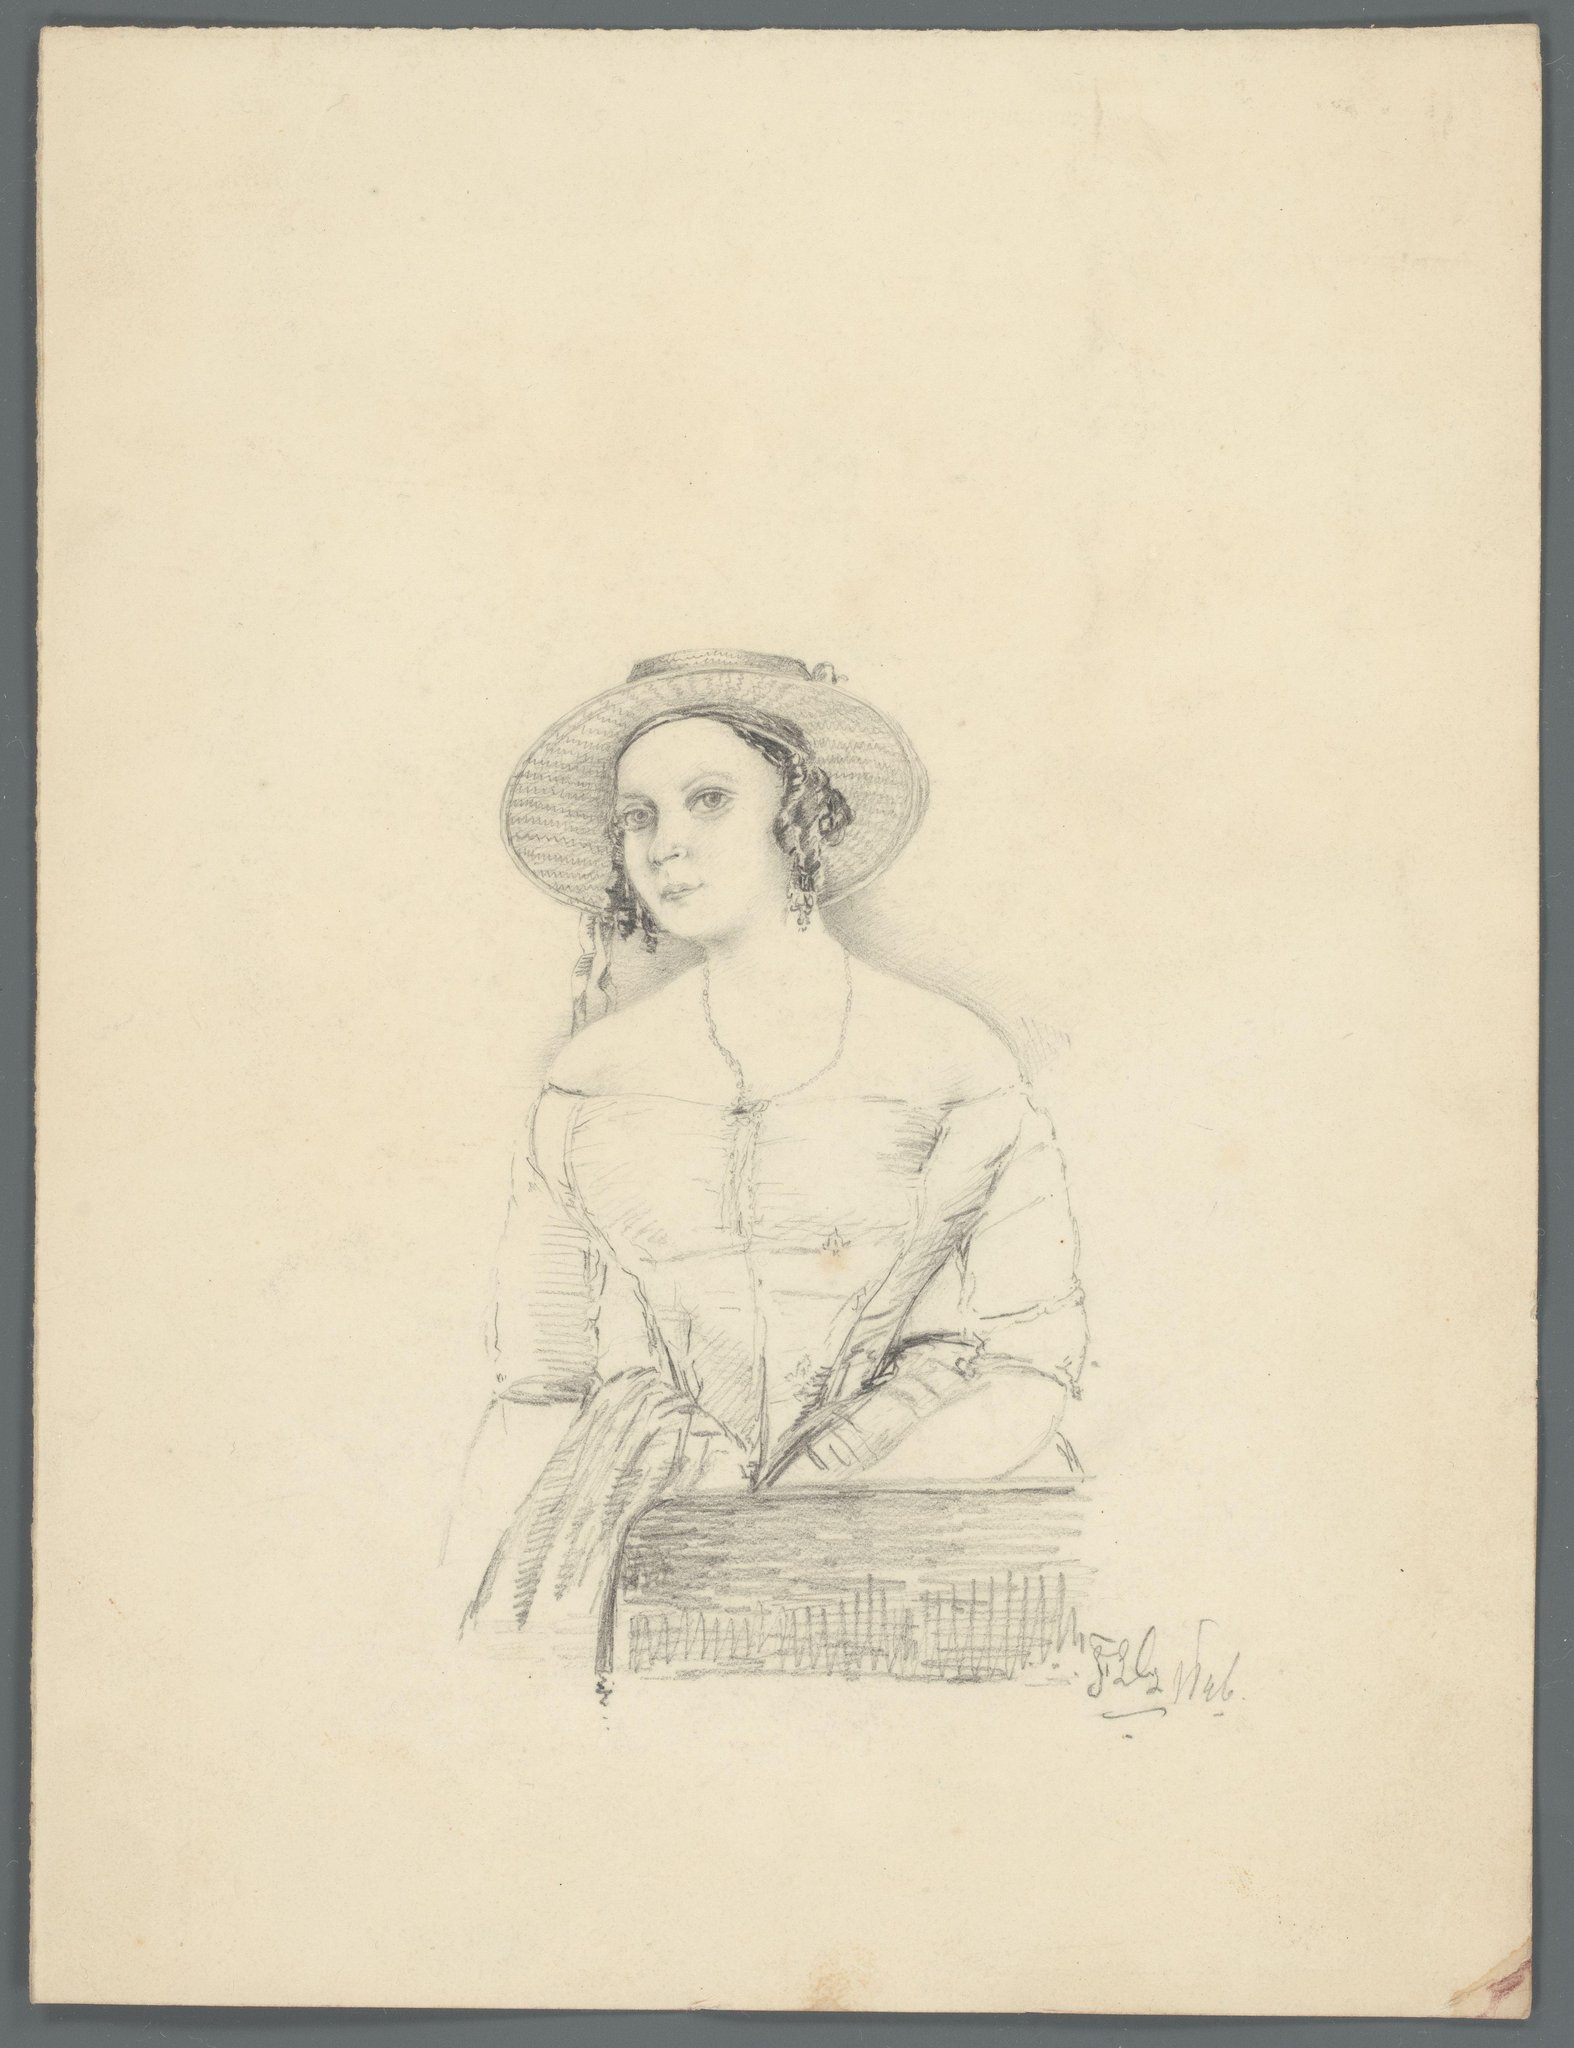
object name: drawing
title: Jonge vrouw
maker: frederik lambertus geerling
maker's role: naval officer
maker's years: 1815-1894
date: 1846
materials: paper, pencil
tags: historical persons not known by name - bb - woman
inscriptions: date